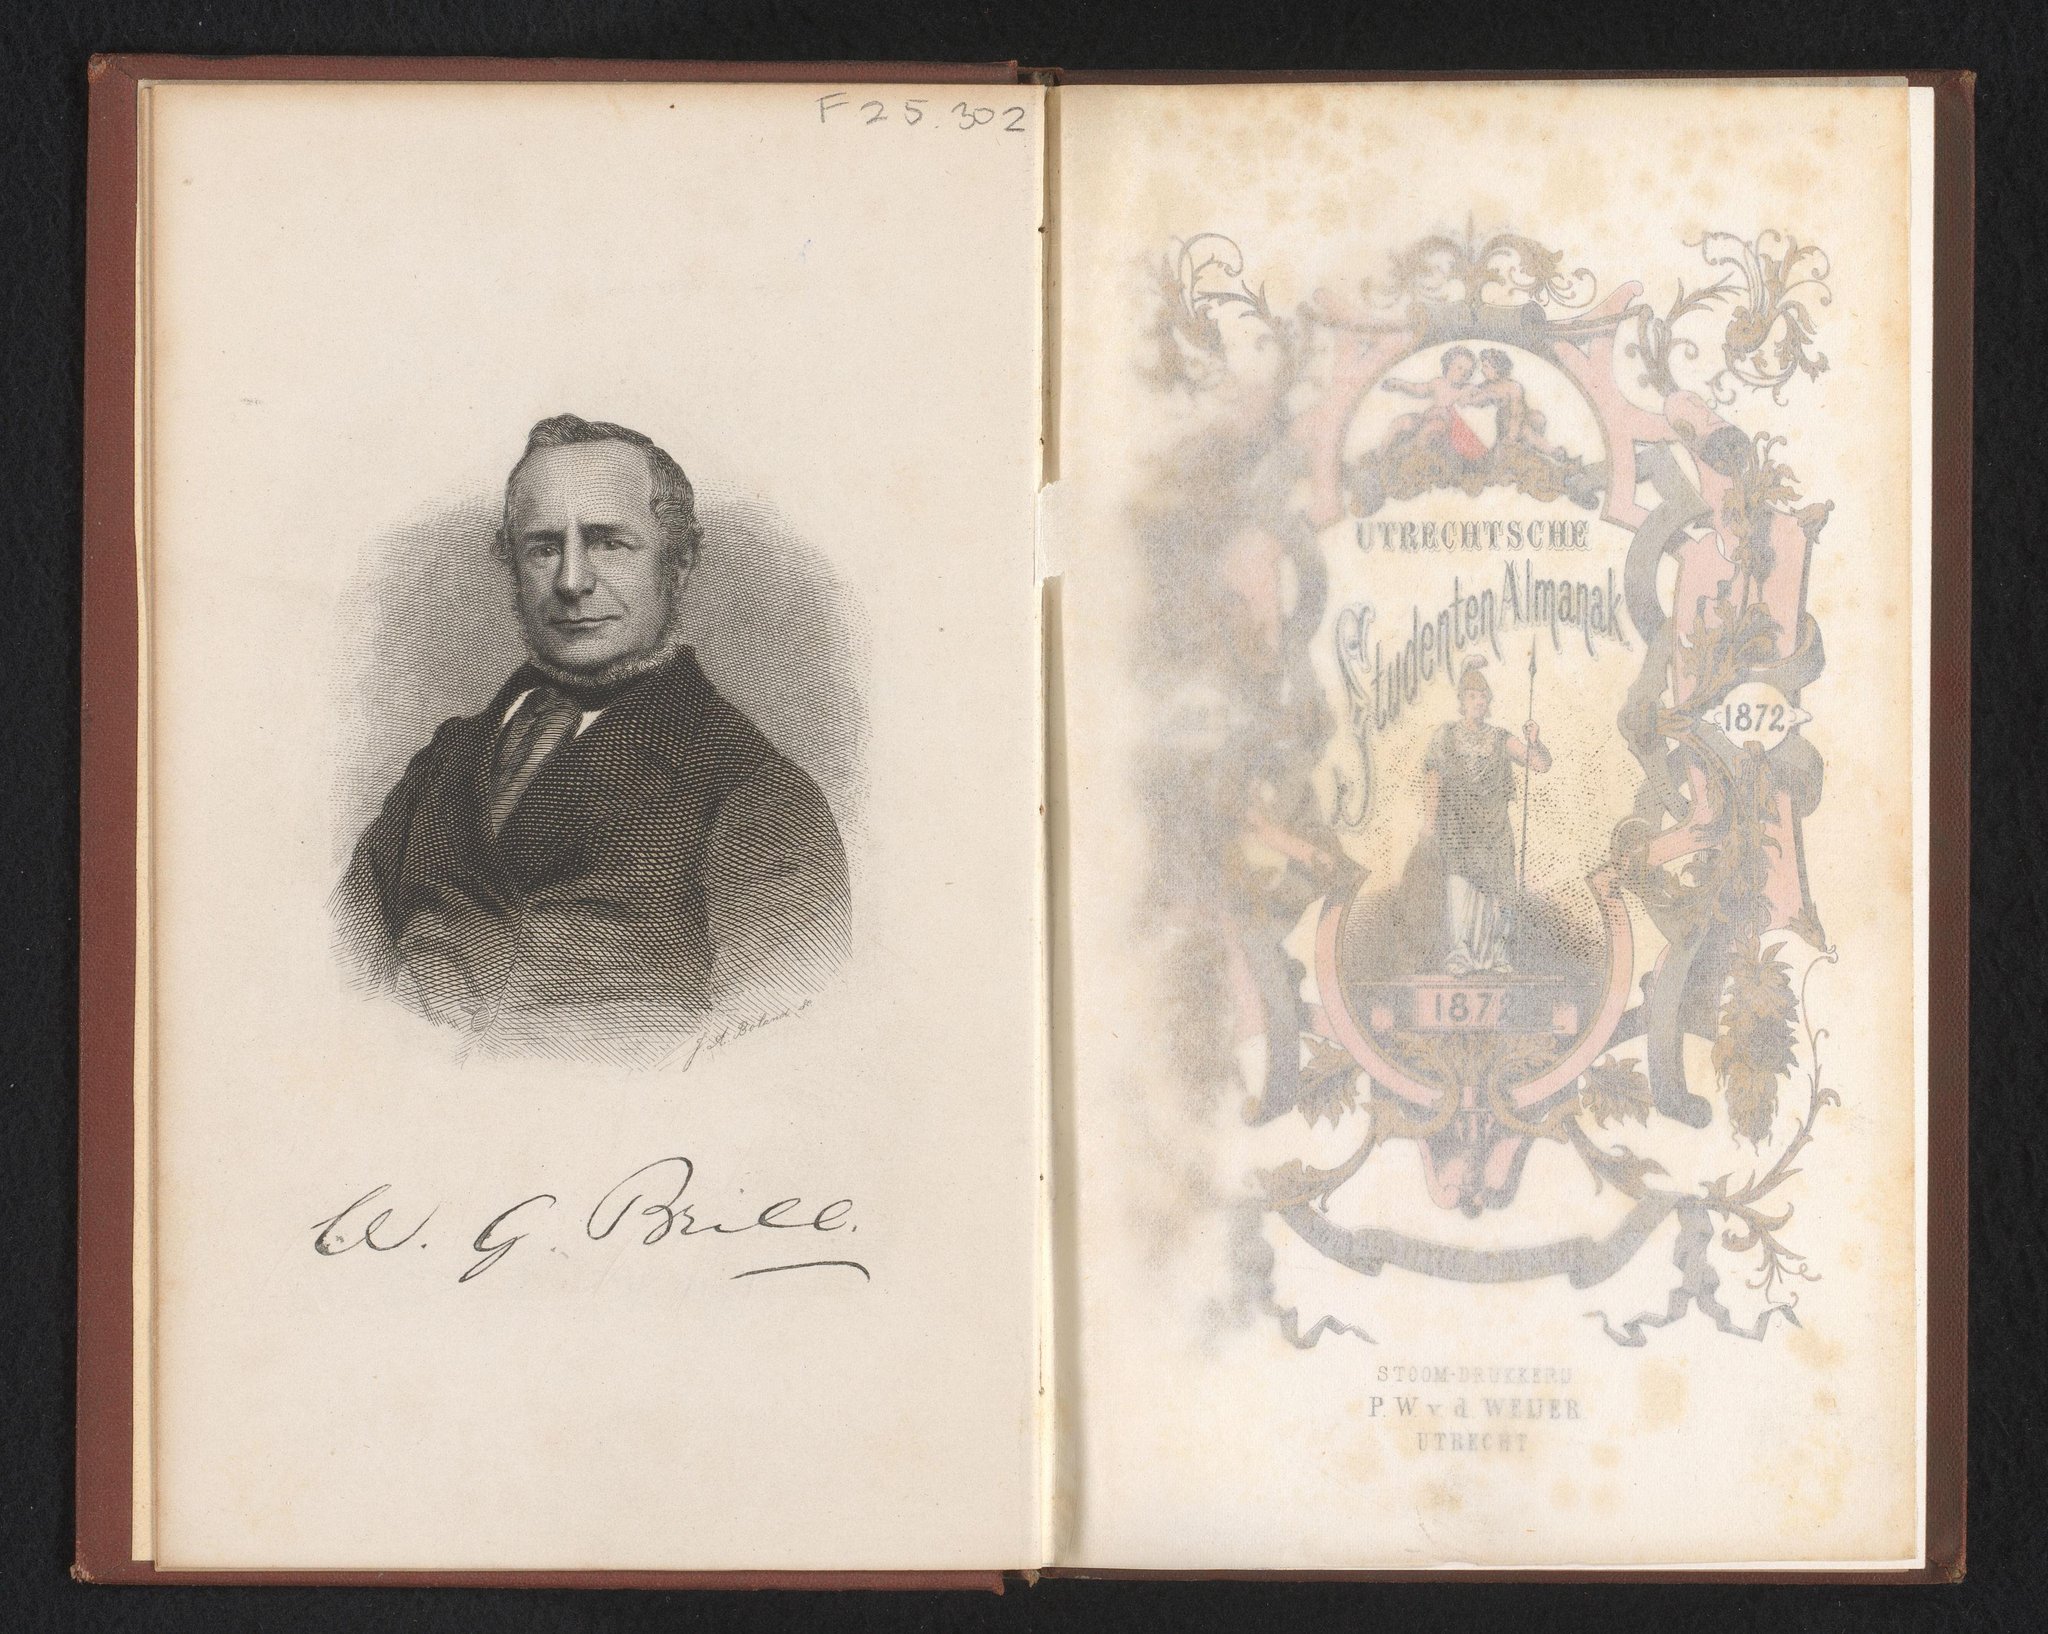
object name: print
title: Portret van W.G. Brill, hoogleraar wijsbegeerte en letteren en rector magnificus van de Universiteit Utrecht 1871-1872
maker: johannes arnoldus boland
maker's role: print maker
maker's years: 1838-1922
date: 1866-1871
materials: paper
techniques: engraving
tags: historical persons, professor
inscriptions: signature: ‘W.G. Brill’